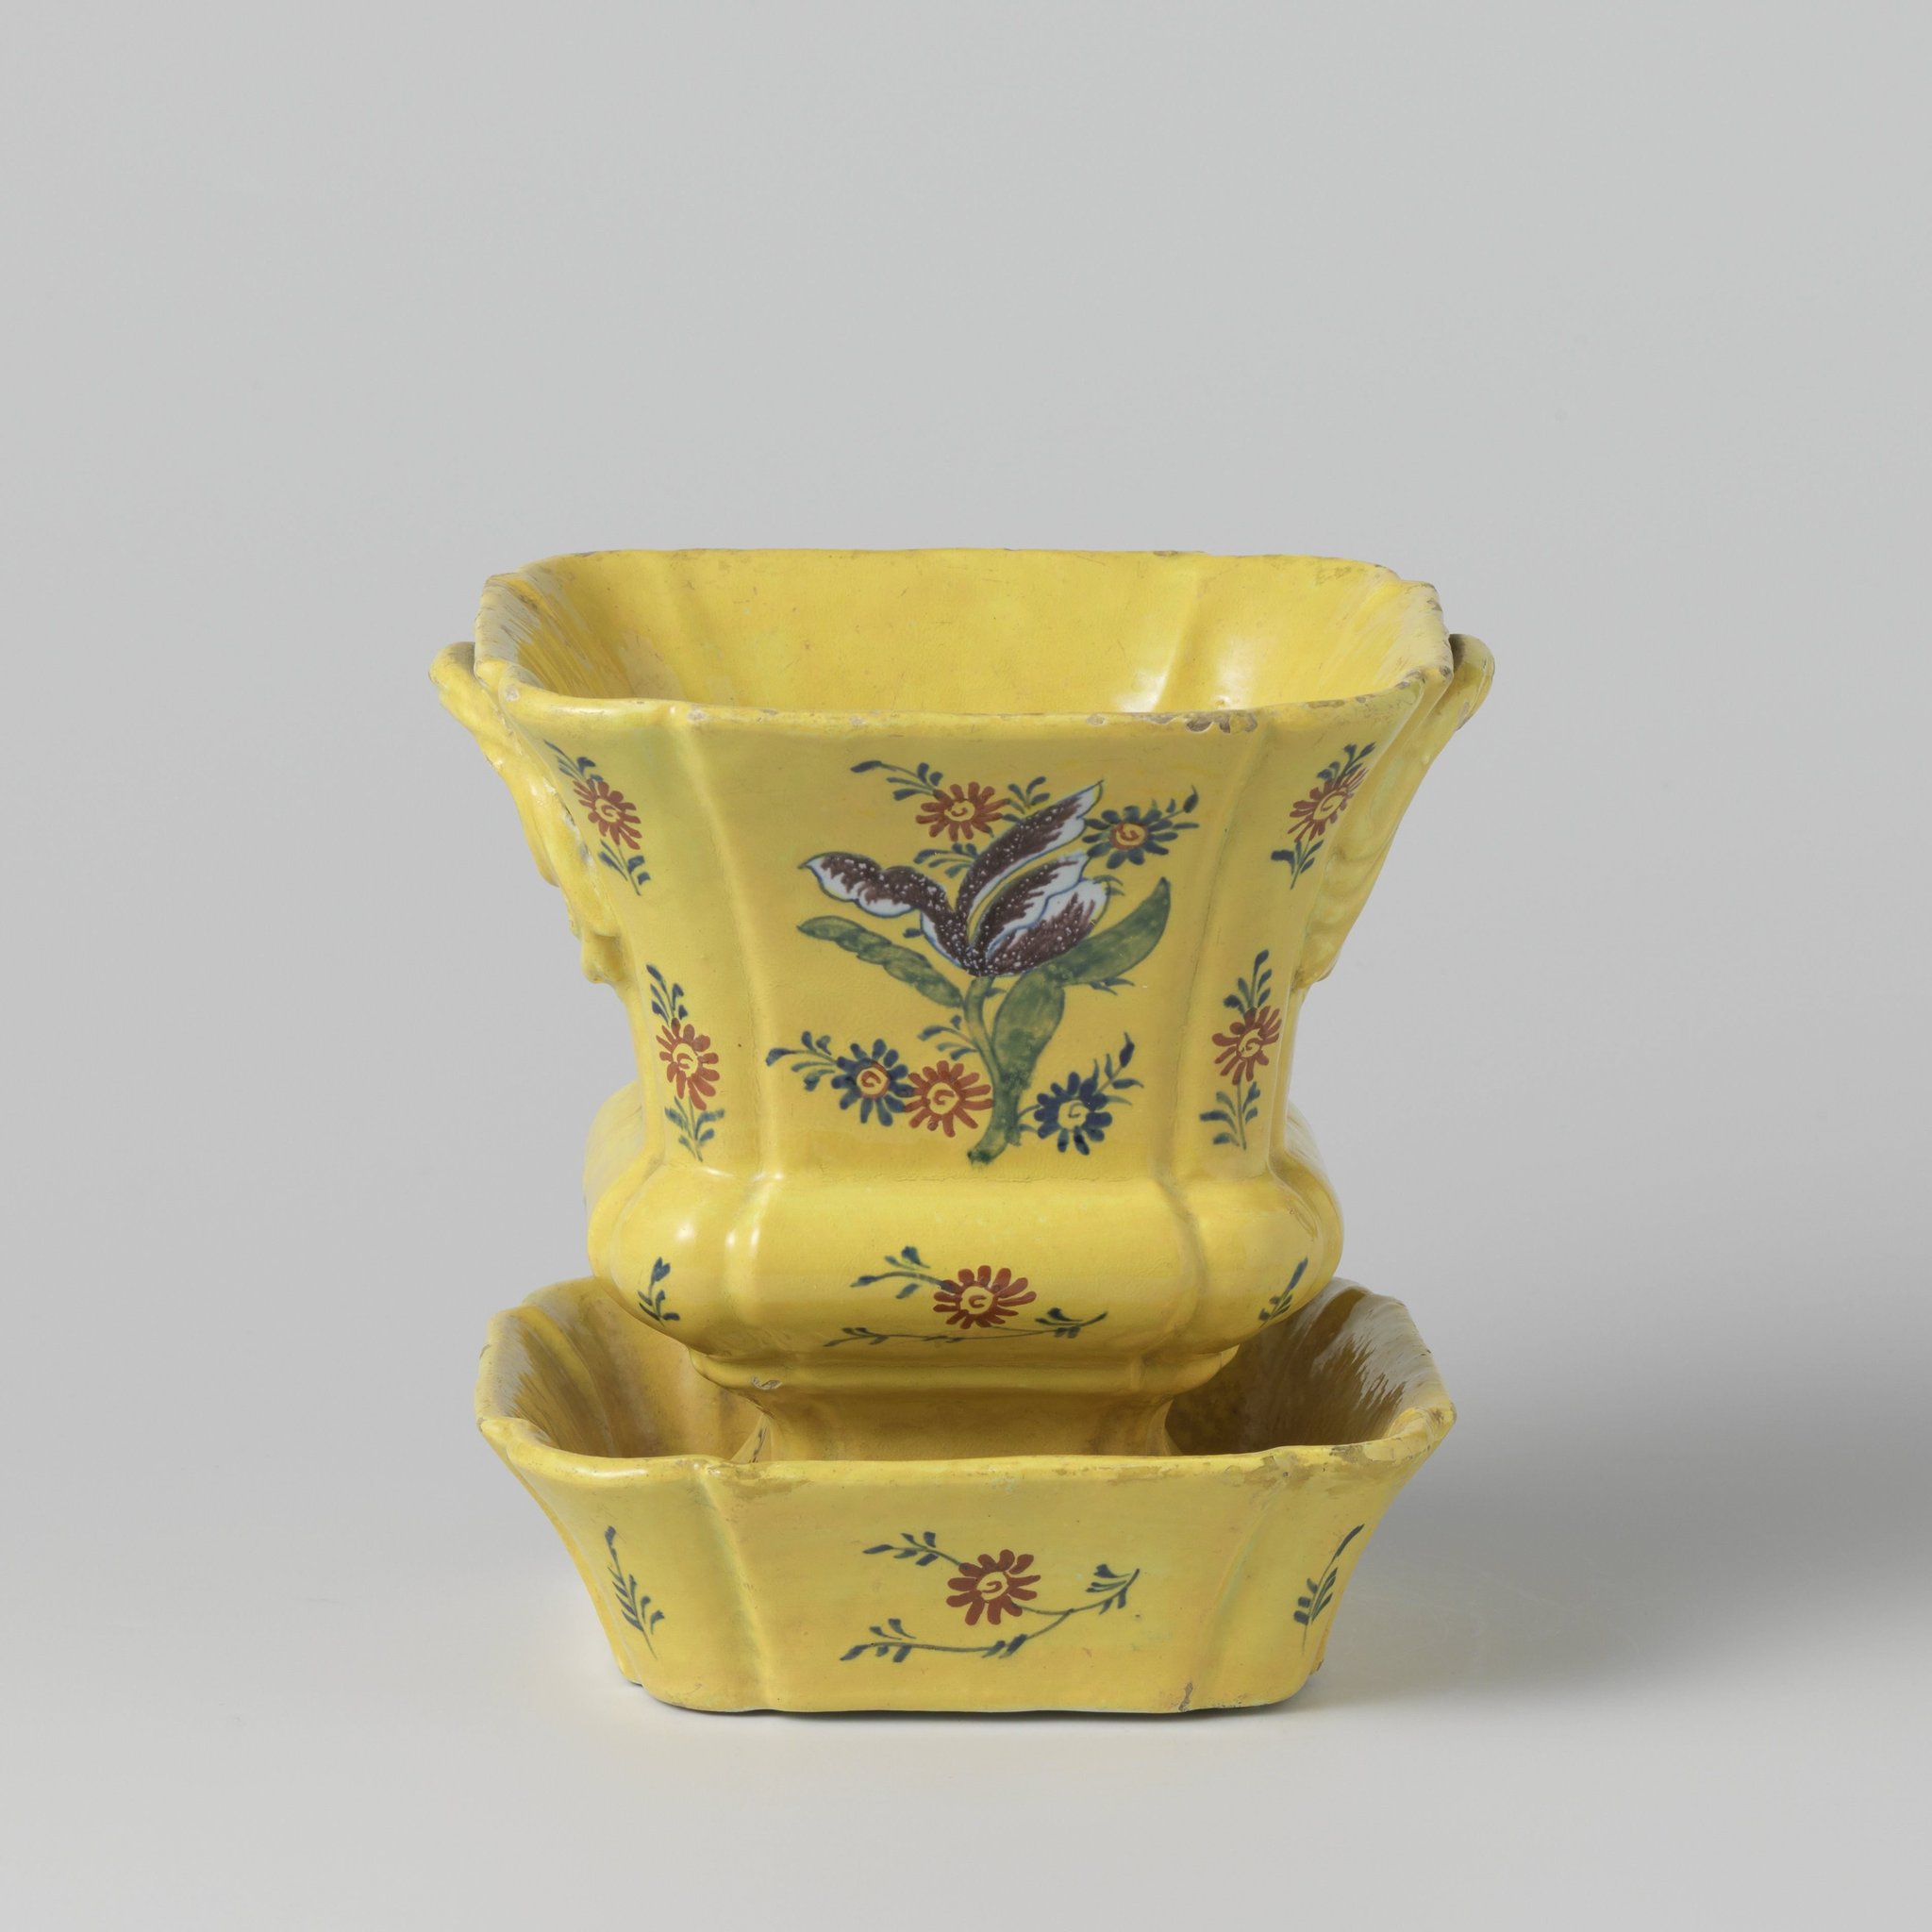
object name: platter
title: Onderschotel van veelkleurig beschilderde faience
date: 1750-1775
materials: earthenware, glaze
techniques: painted, polychromy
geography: delft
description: Bloempot van veelkleurig beschilderde faience op een geel fond. De bloempot bestaat uit een vaas en een schotel in Lodewijk XVde stijl. De bloempot en de schotel zijn versierd met tulpen en madelieven en gemerkt met de letters LPK. Bij de bloempot hoort een identiek exemplaar met het invnr. BK-NM-11351-B.